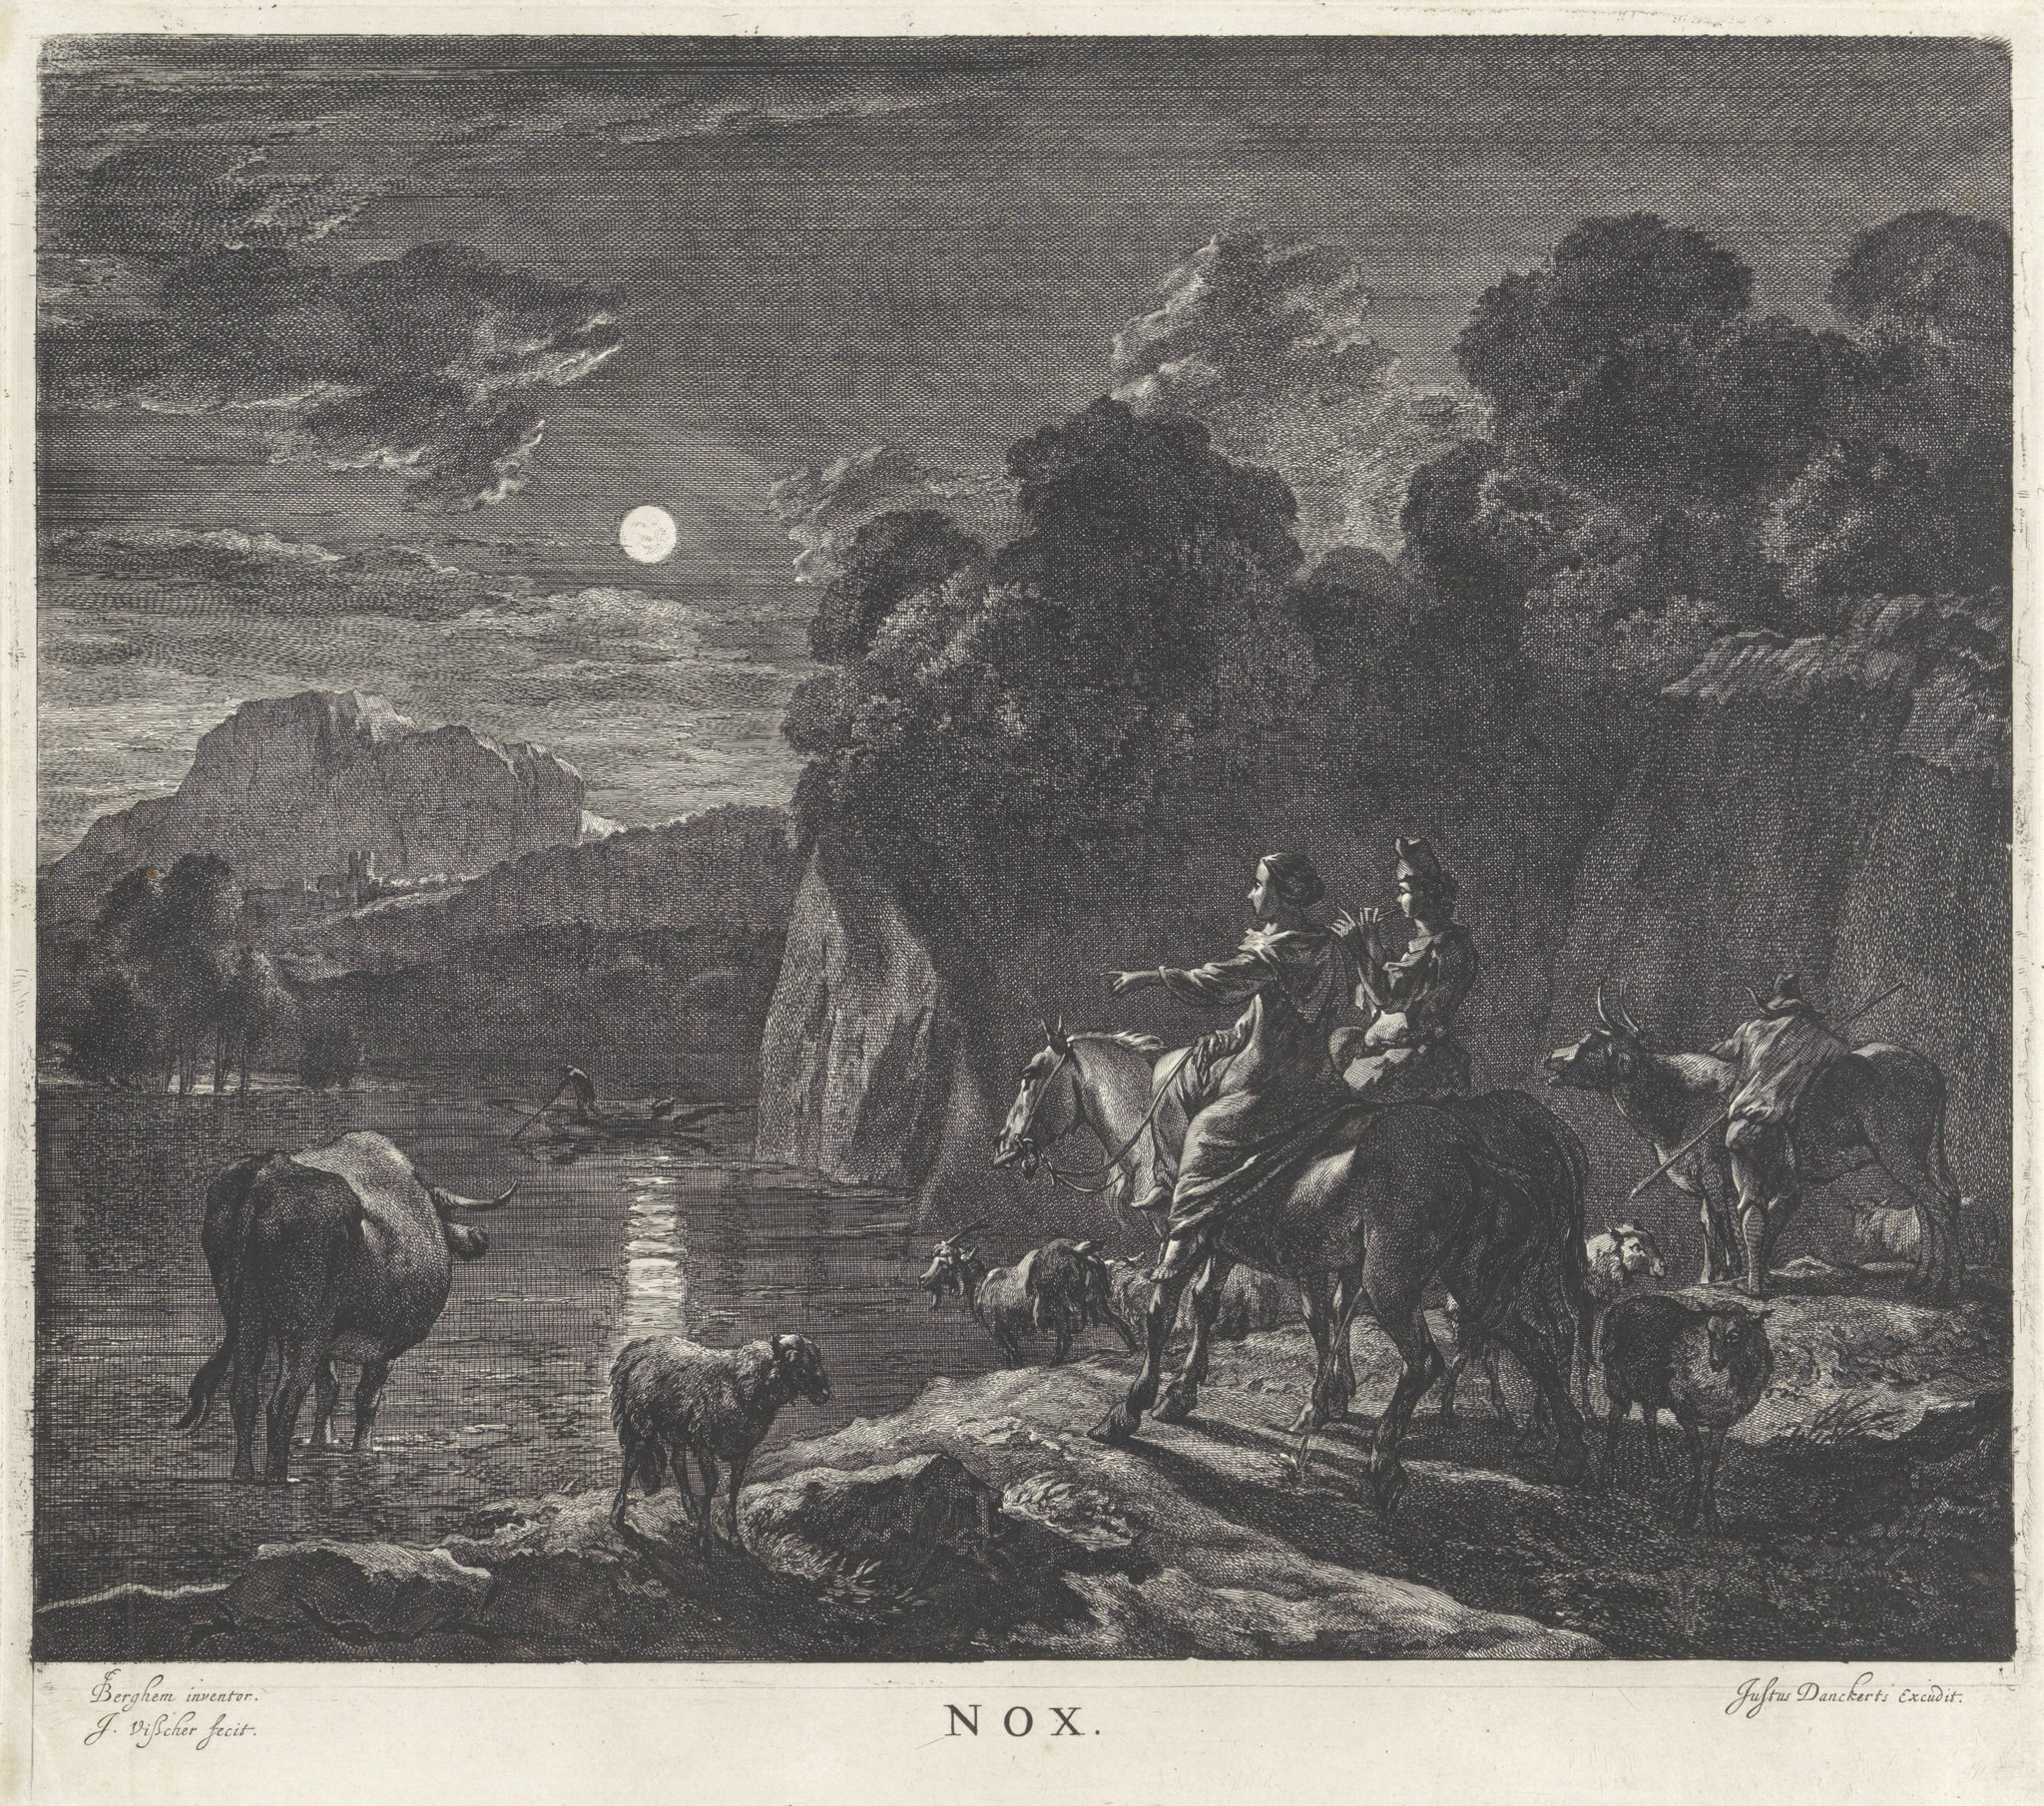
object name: print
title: NOX.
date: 1645-1701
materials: paper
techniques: engraving, etching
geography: amsterdam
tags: moonlight, cattle driving, cattle driver, night ~ landscape (sometimes titled 'nox')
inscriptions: signature: ‘Berghem inventor’, signature: ‘J. Visscher fecit’, collector's mark: Lugt 240, title: ‘NOX’, address: ‘Justus Danckerts Excudit’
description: Gezicht op een heuvelachtig landschap bij nacht. De volle maan schijnt. Een herder en herderin te paard laten hun vee drinken uit een meer. Op de achtergrond een man in een bootje en de contouren van een dorp.